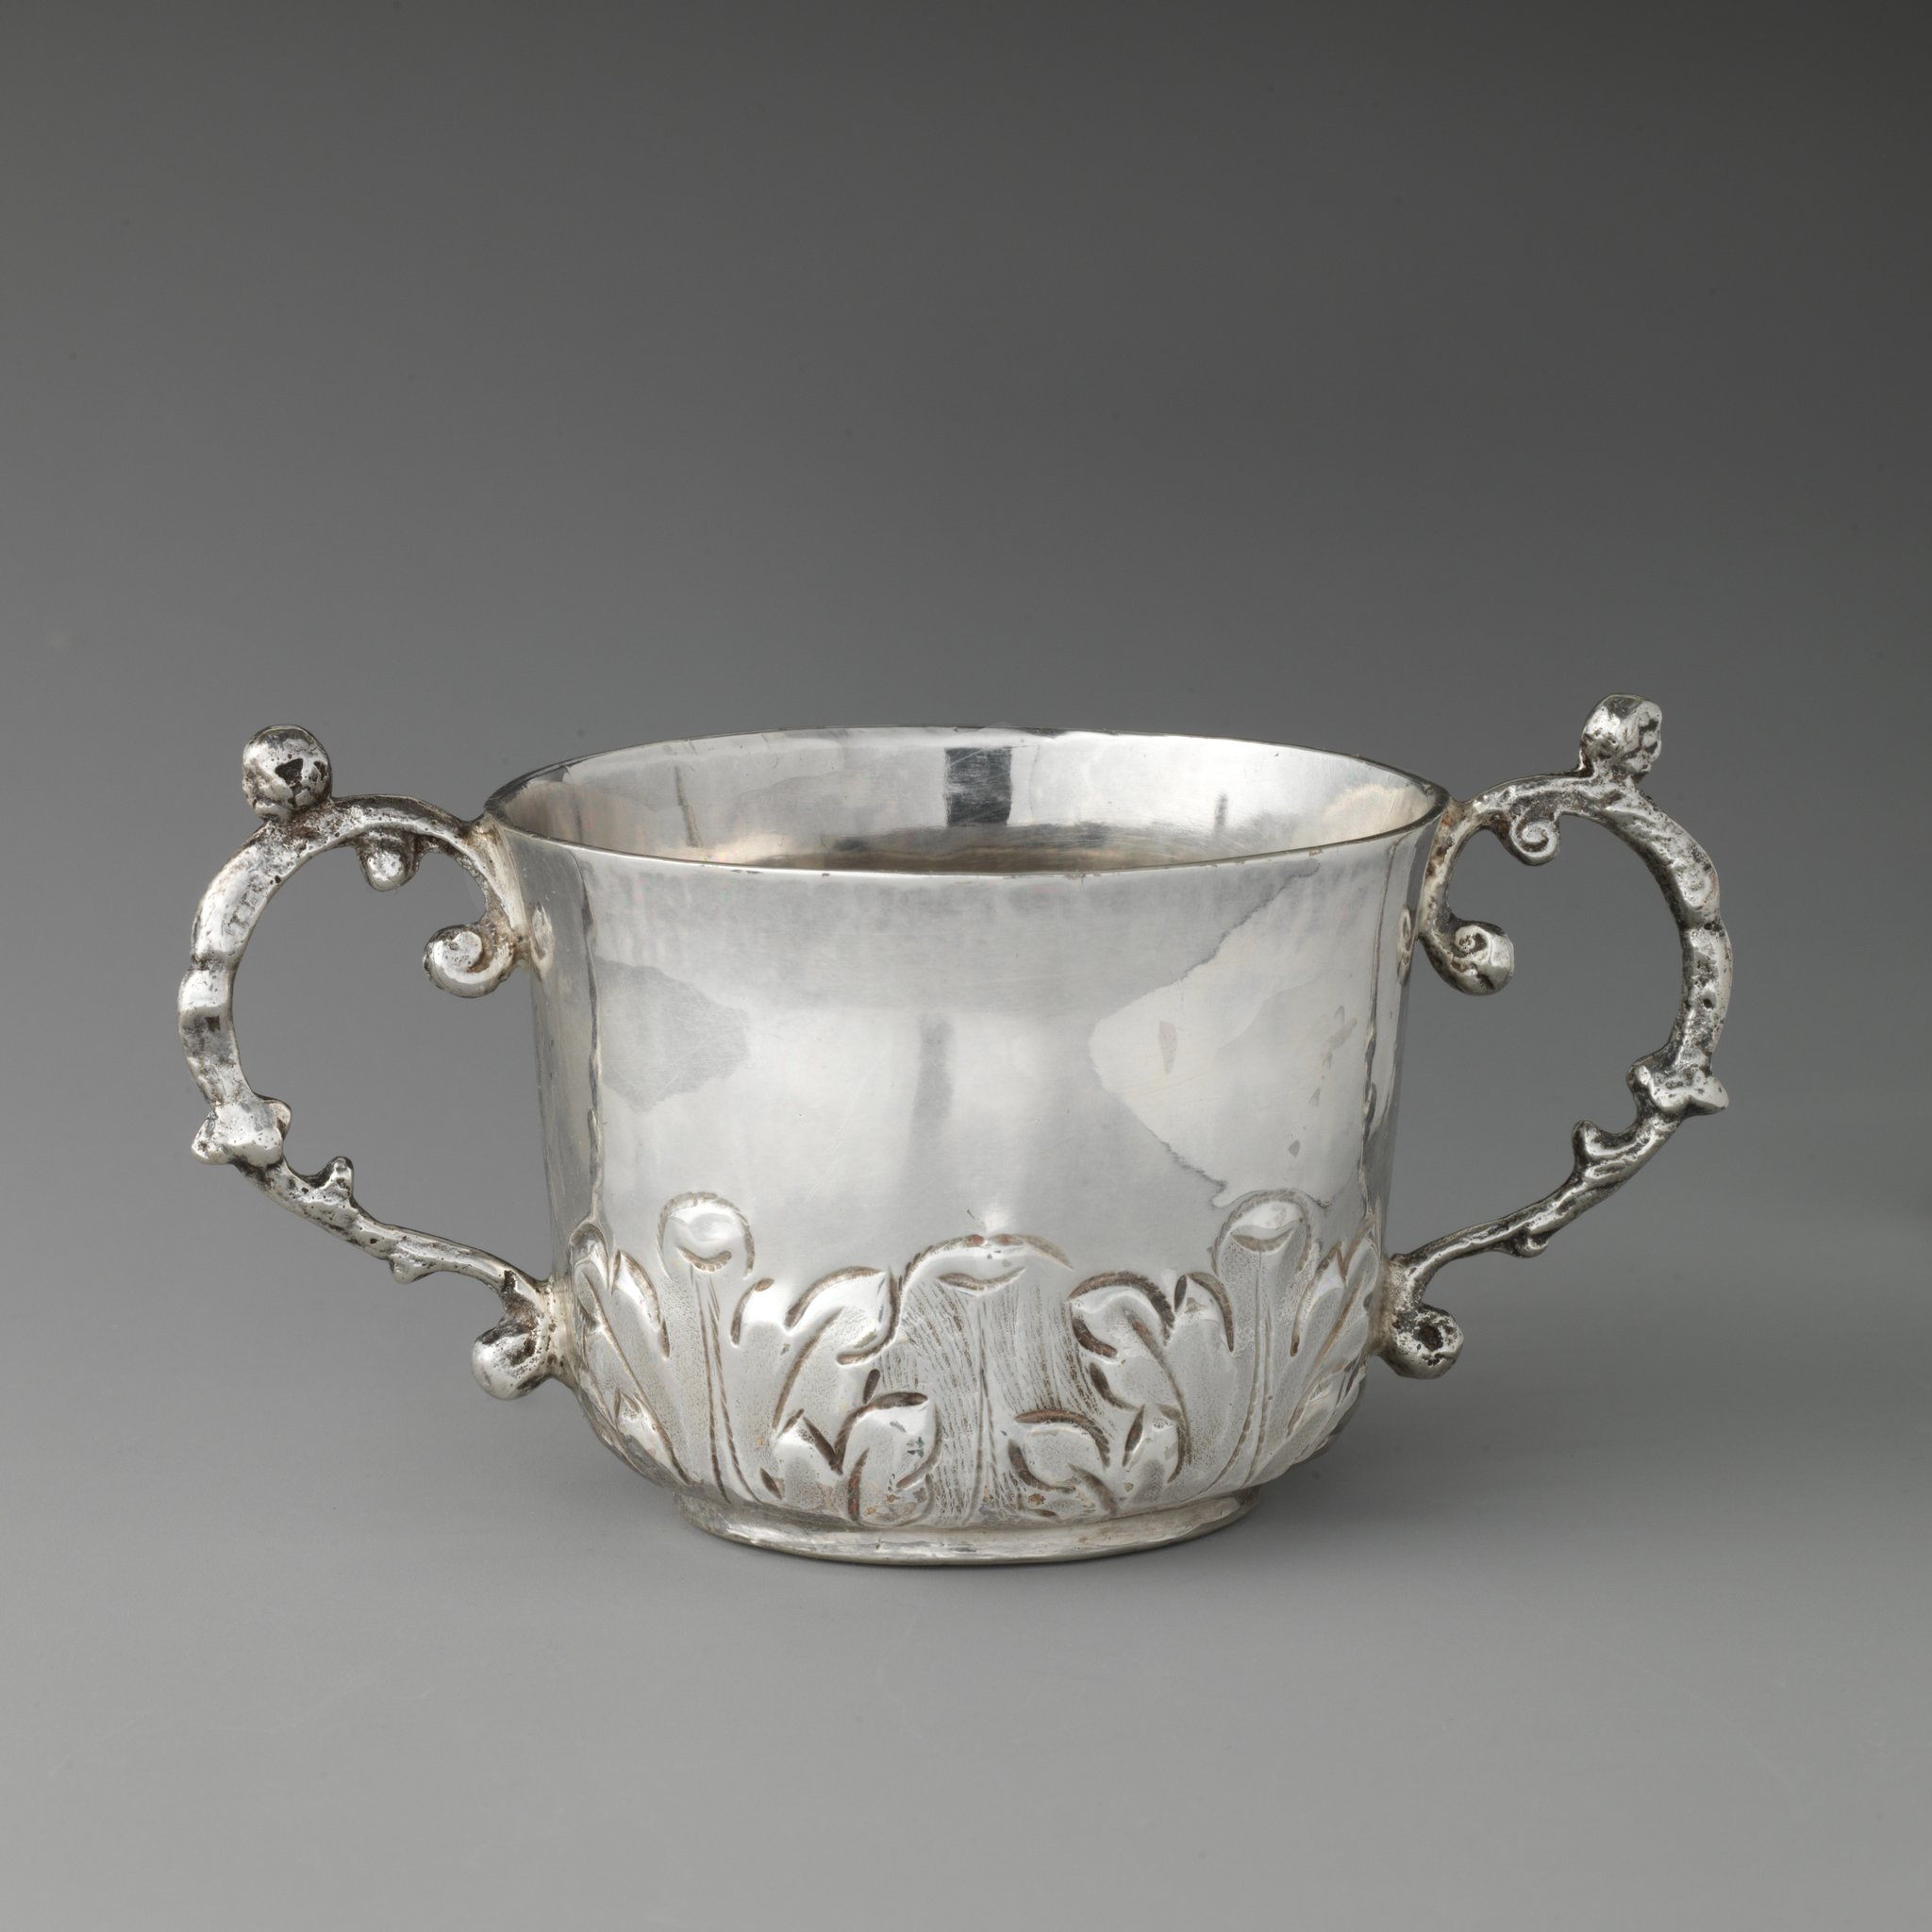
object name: caudle cup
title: Miniature child's caudle cup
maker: s h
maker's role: maker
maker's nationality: british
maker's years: 1650-1699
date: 1680-1681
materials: silver